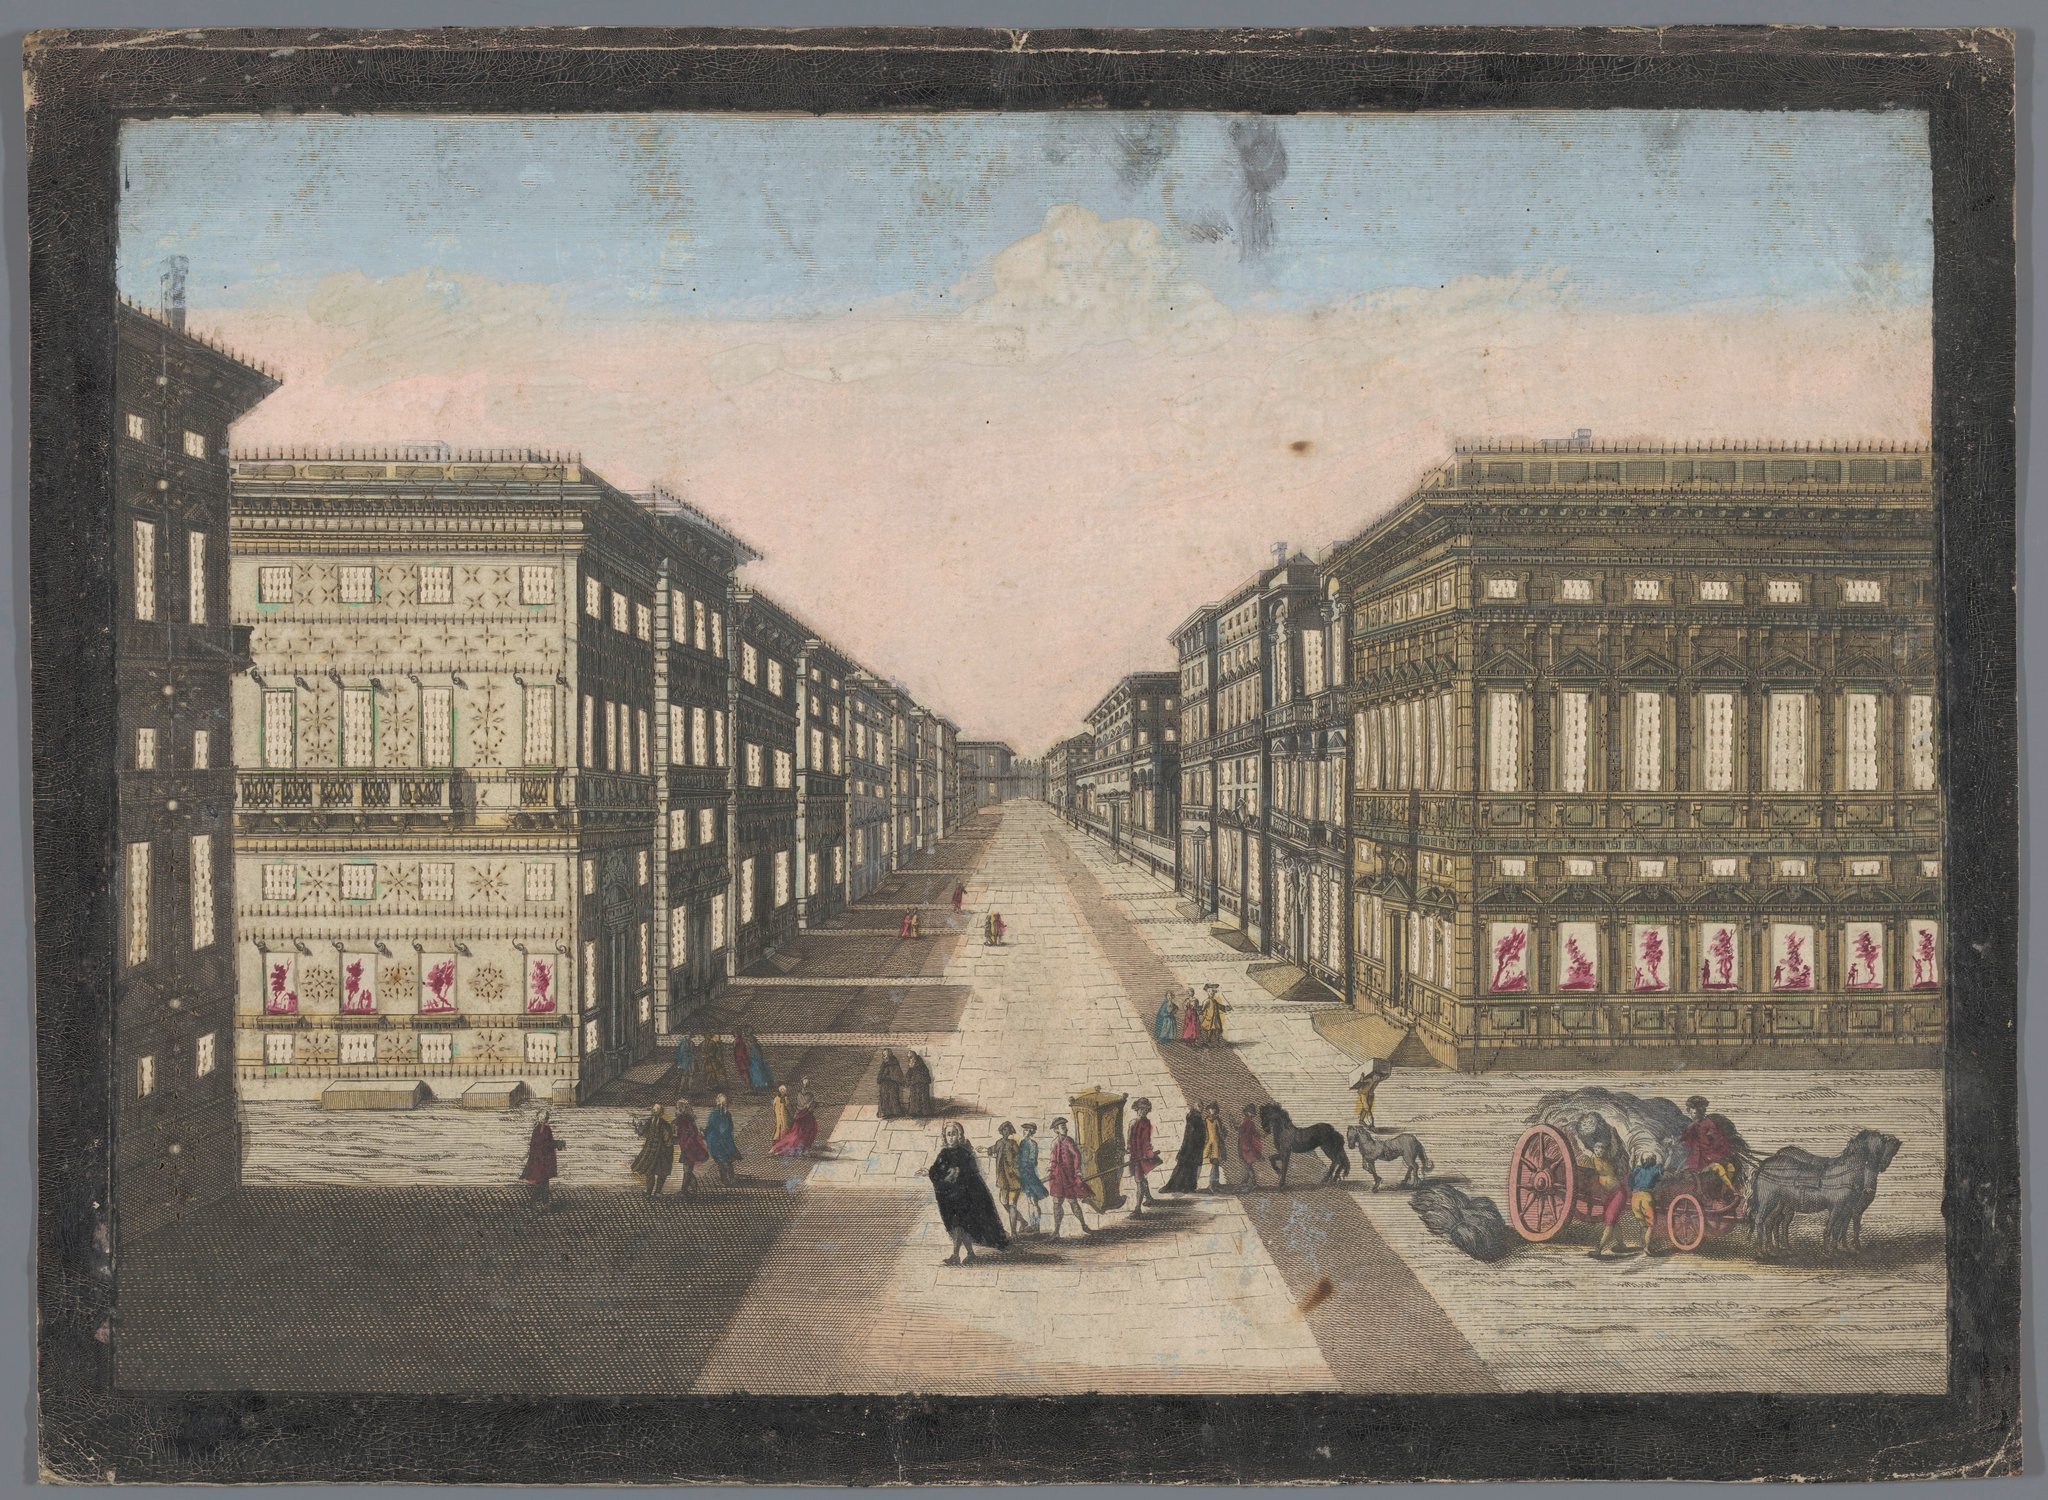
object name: print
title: Veduta di Strada Nuova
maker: Anonymous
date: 1700-1799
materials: cardboard, paint, paper, watercolor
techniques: brush, cutting, etching, perforating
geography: italy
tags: street (+ city(-scape) with figures, staffage)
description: In de prent is een aantal delen weggesneden waar vervolgens met penseel is getekend. Mogelijk rechtsonder genummerd geweest: Gg 4.